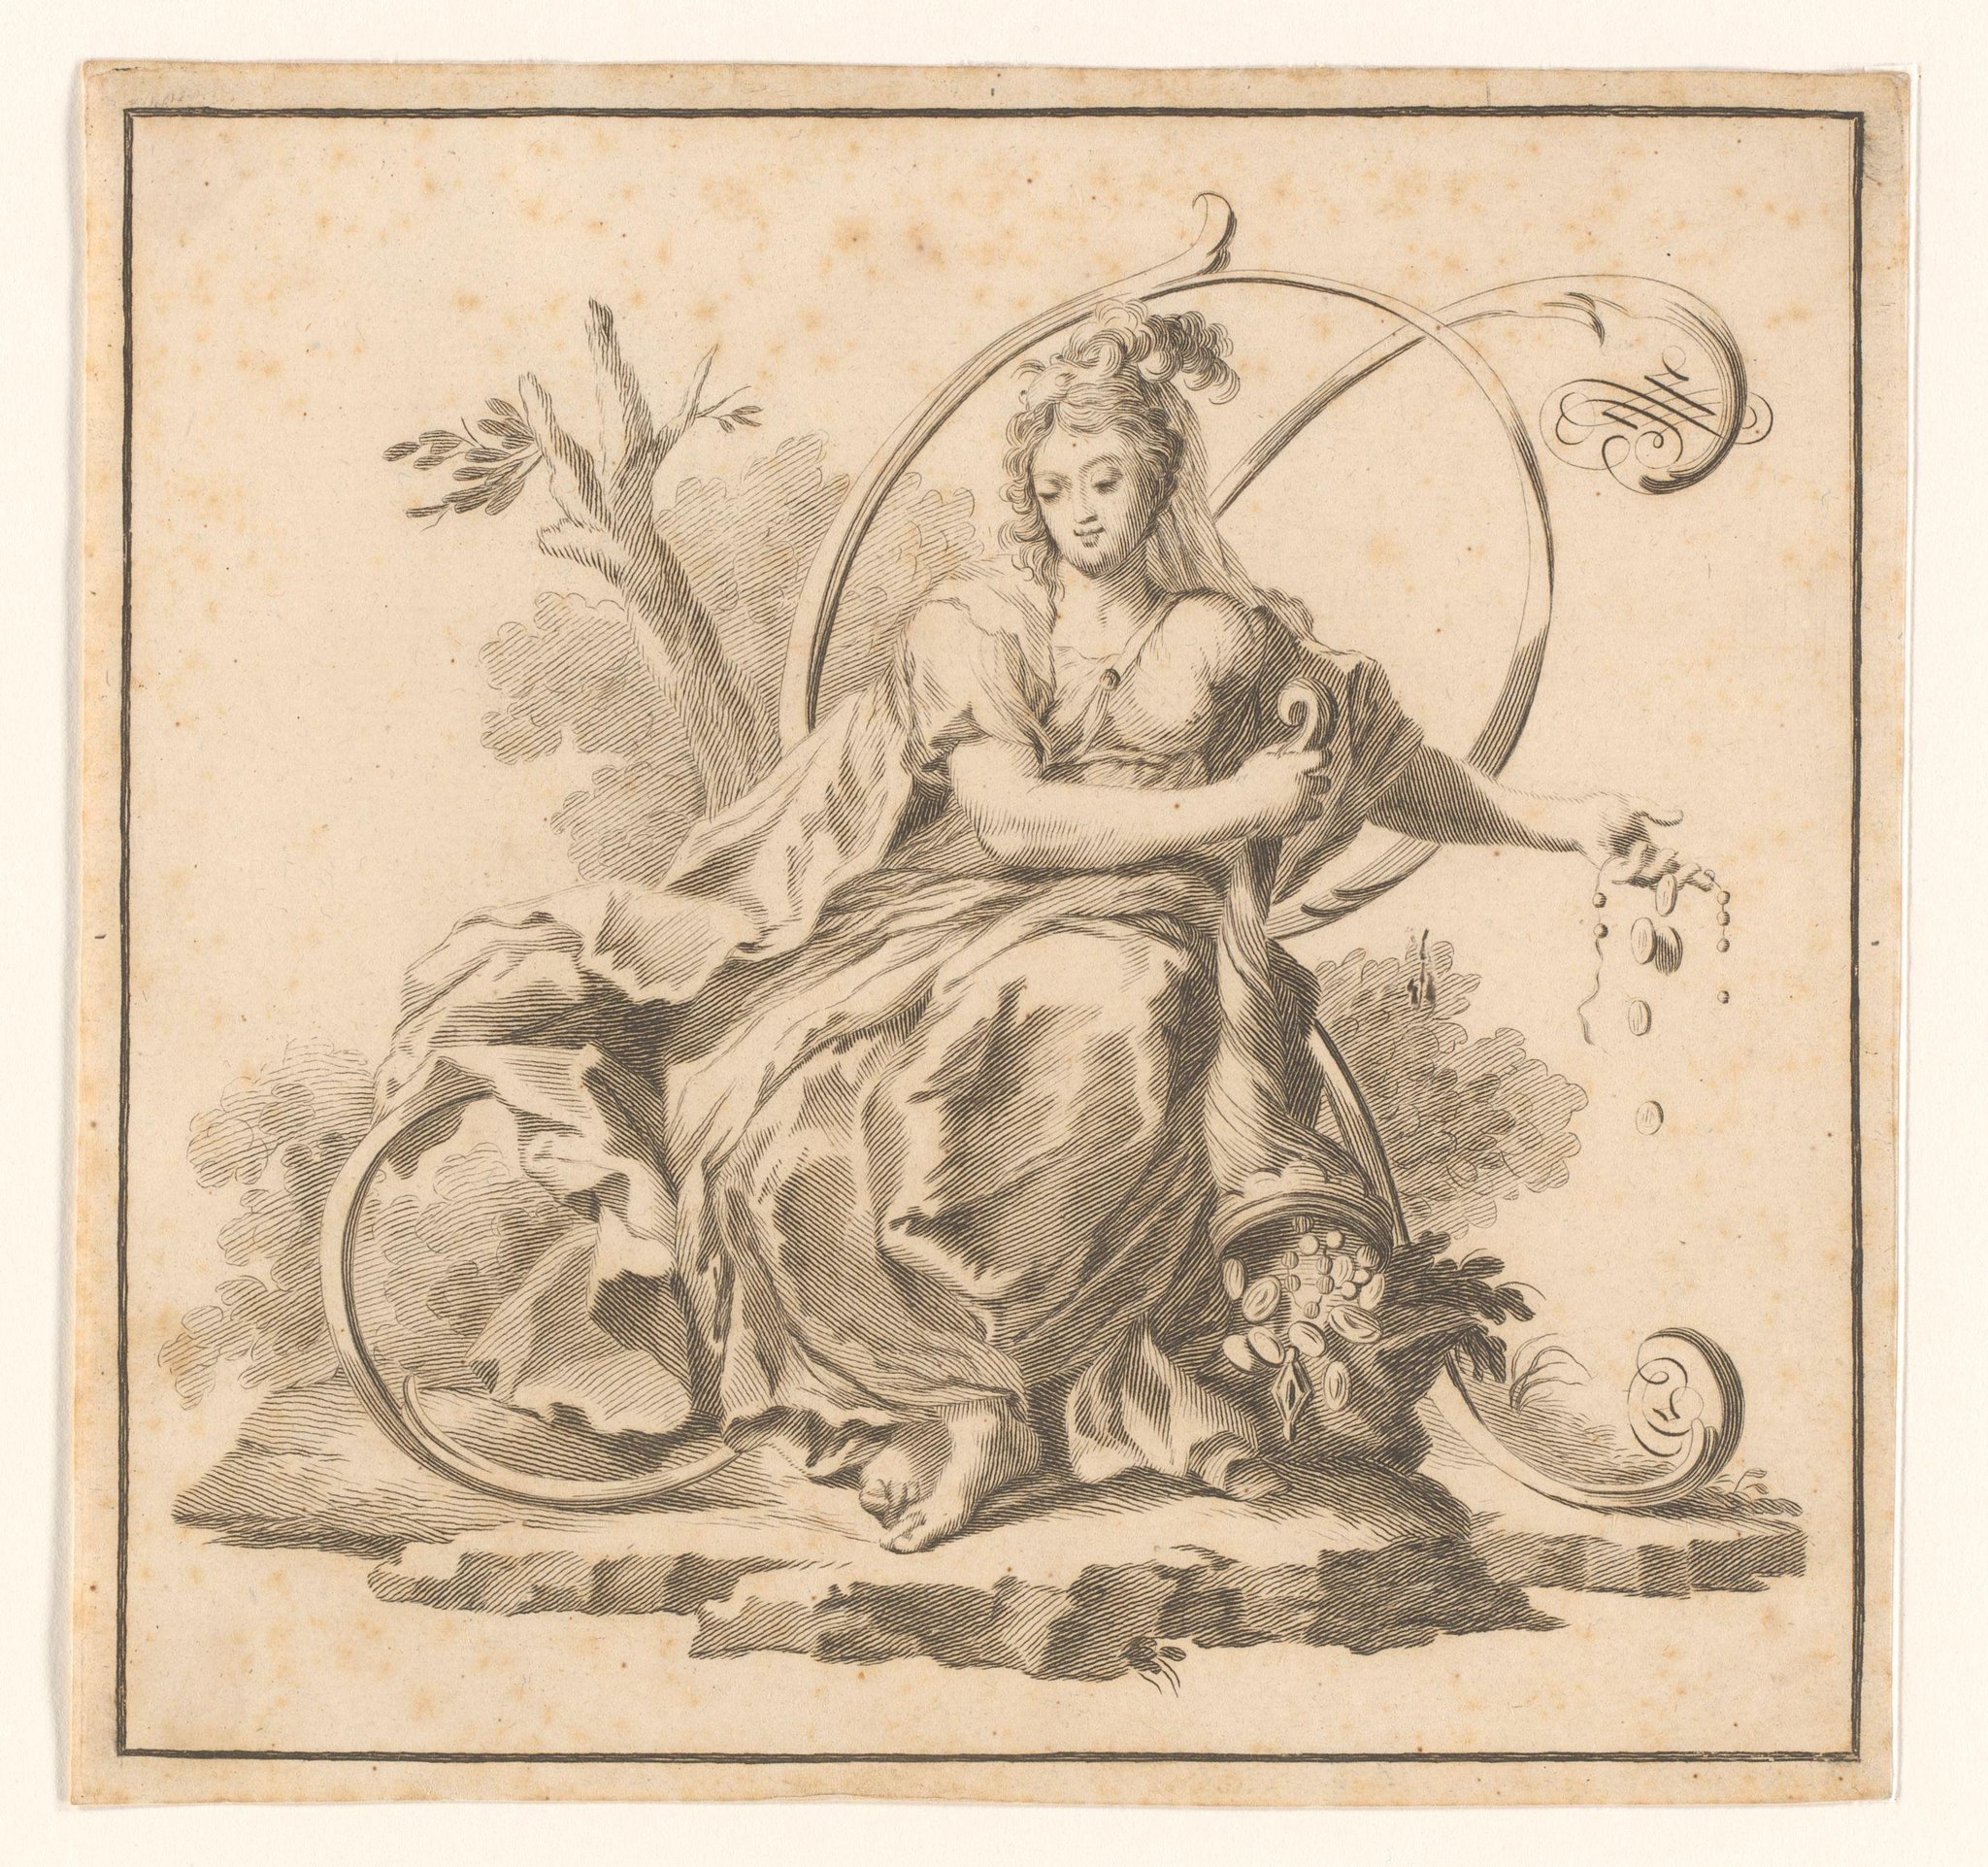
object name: print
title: Overvloed (Abundantia)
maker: Anonymous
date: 1670-1750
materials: paper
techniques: engraving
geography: germany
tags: 'cornucopia', horn of plenty, abundance; 'abondanza', 'abondanza maritima' (ripa)